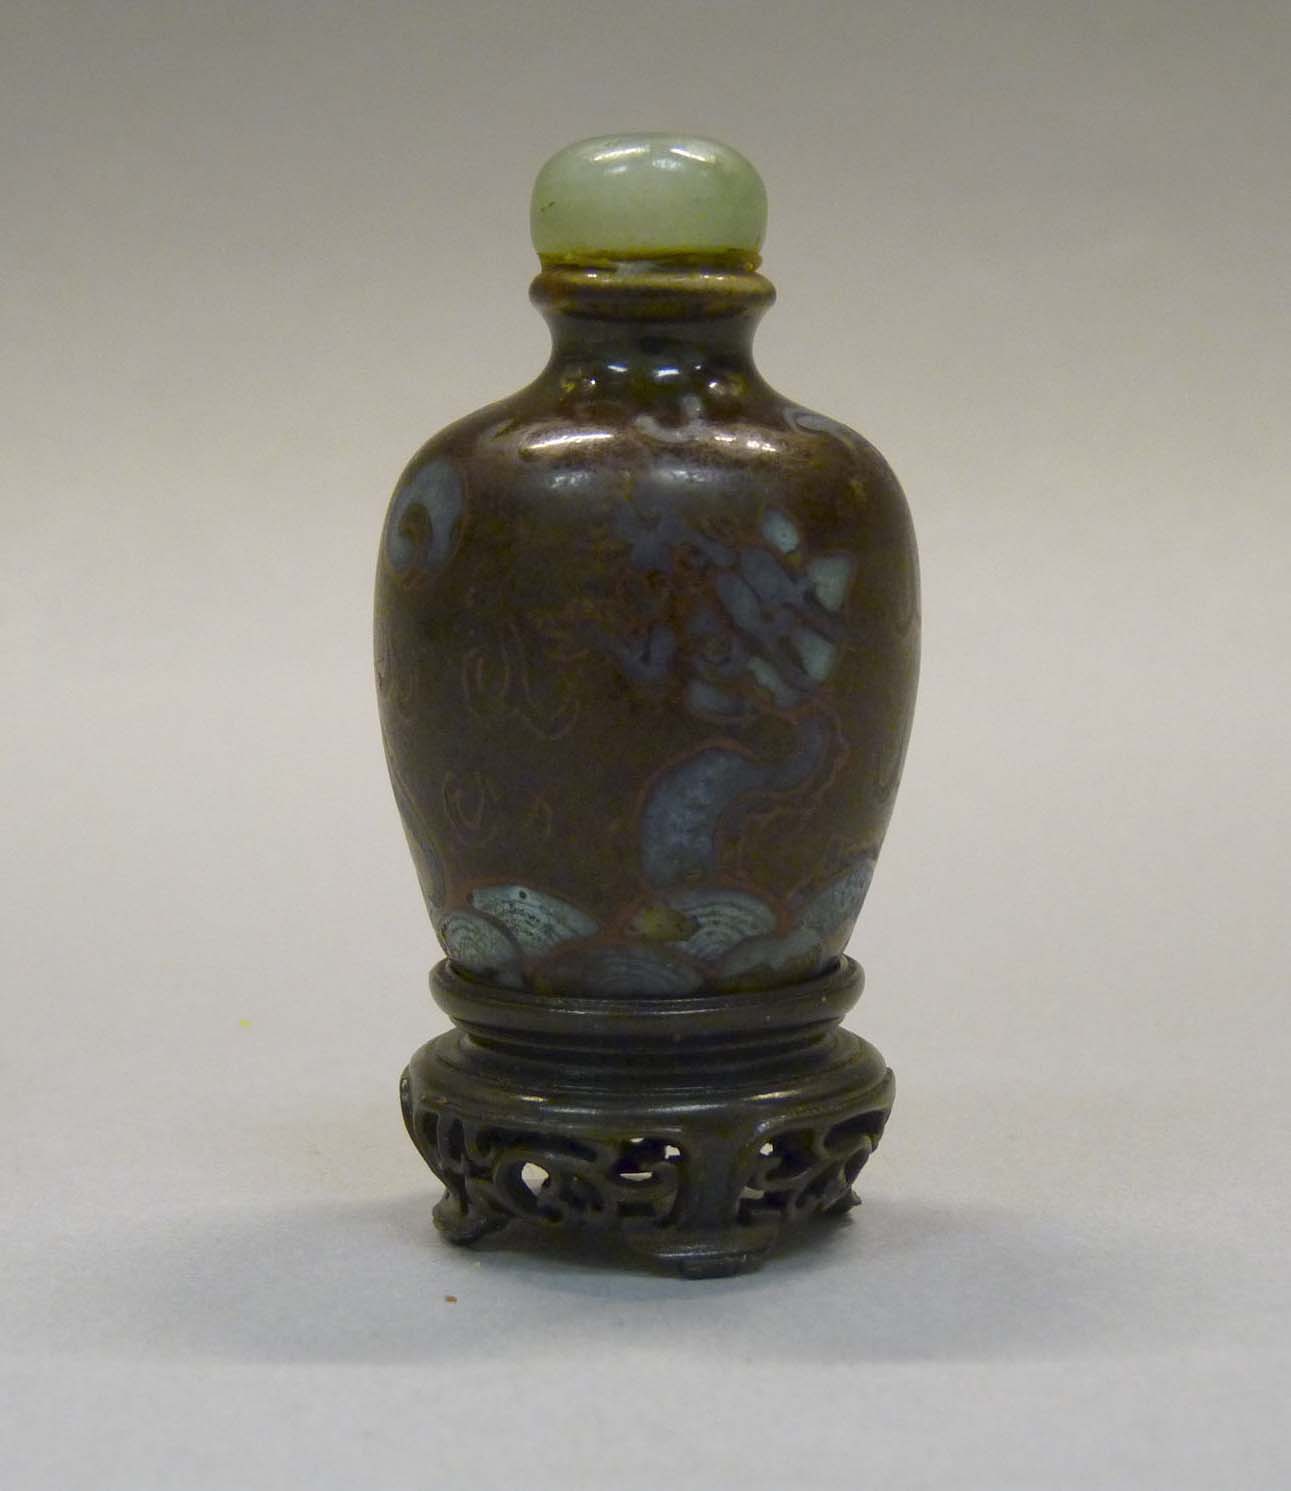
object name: snuff bottle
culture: chinese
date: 1801-1900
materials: jade, porcelain